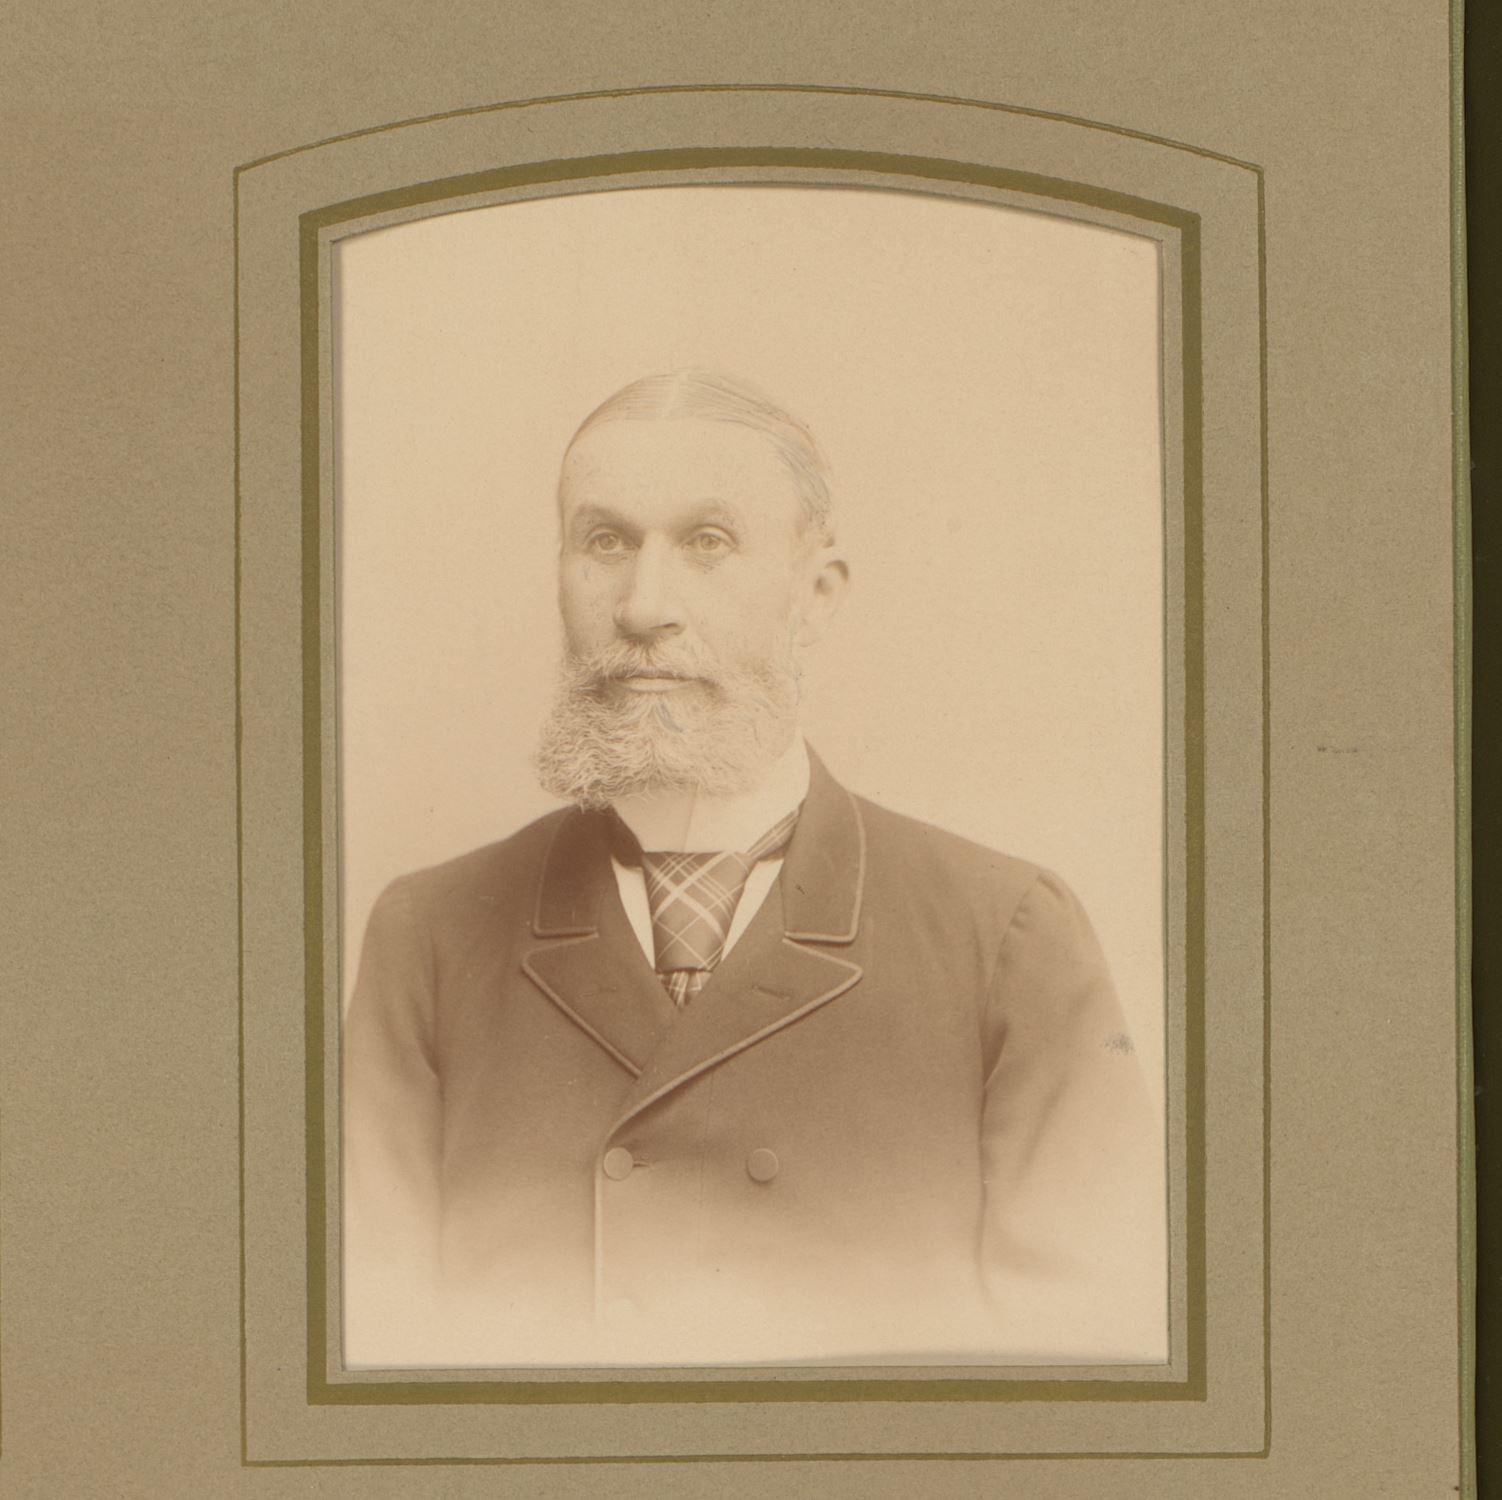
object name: cabinet photograph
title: Portret van een man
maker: emil tiedemann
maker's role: fotograaf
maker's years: 1858-1892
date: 1850-1900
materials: cardboard, photographic support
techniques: albumen print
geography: braunschweig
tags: historical persons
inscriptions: inscription: ‘Emil Tiedemann/ Braunschweig/ 66 Bohlweg 66./ Nachbestellungen beliebe man/ nur in Braunschweig aufzugeben.’